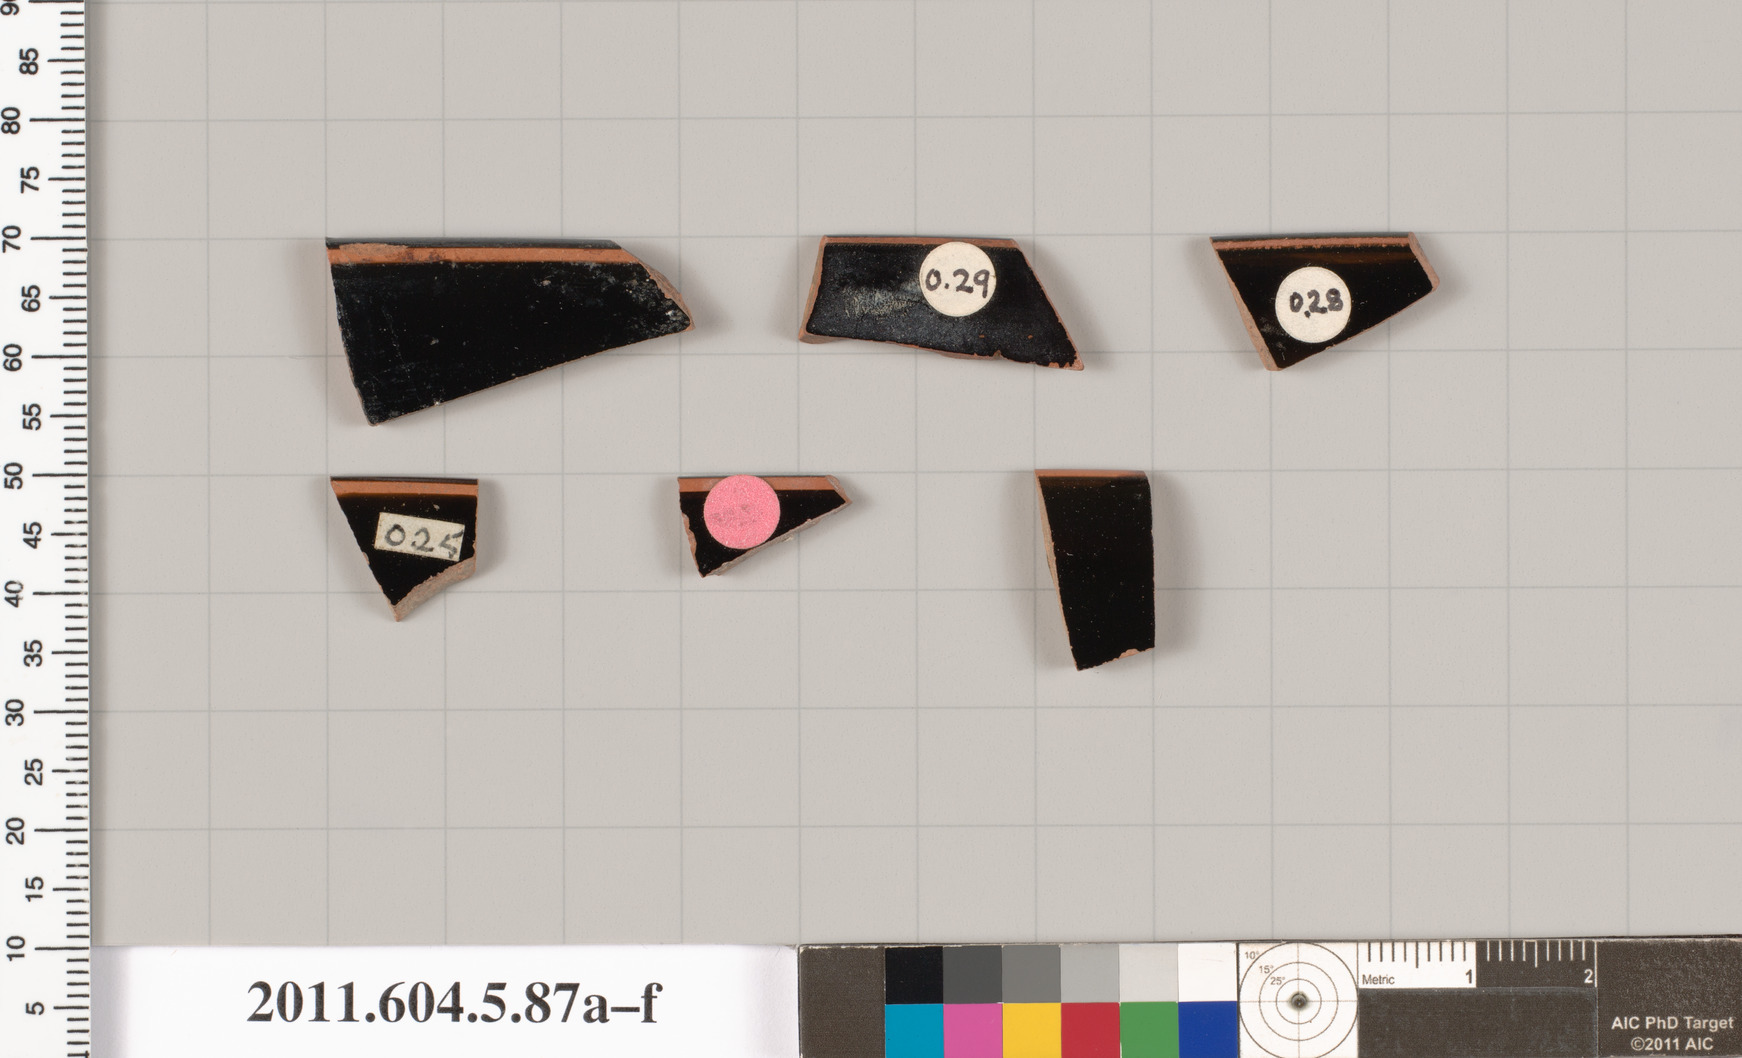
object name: kylix fragment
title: Terracotta rim fragments of kylikes (drinking cups)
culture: greek, attic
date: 510-500 BCE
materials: terracotta